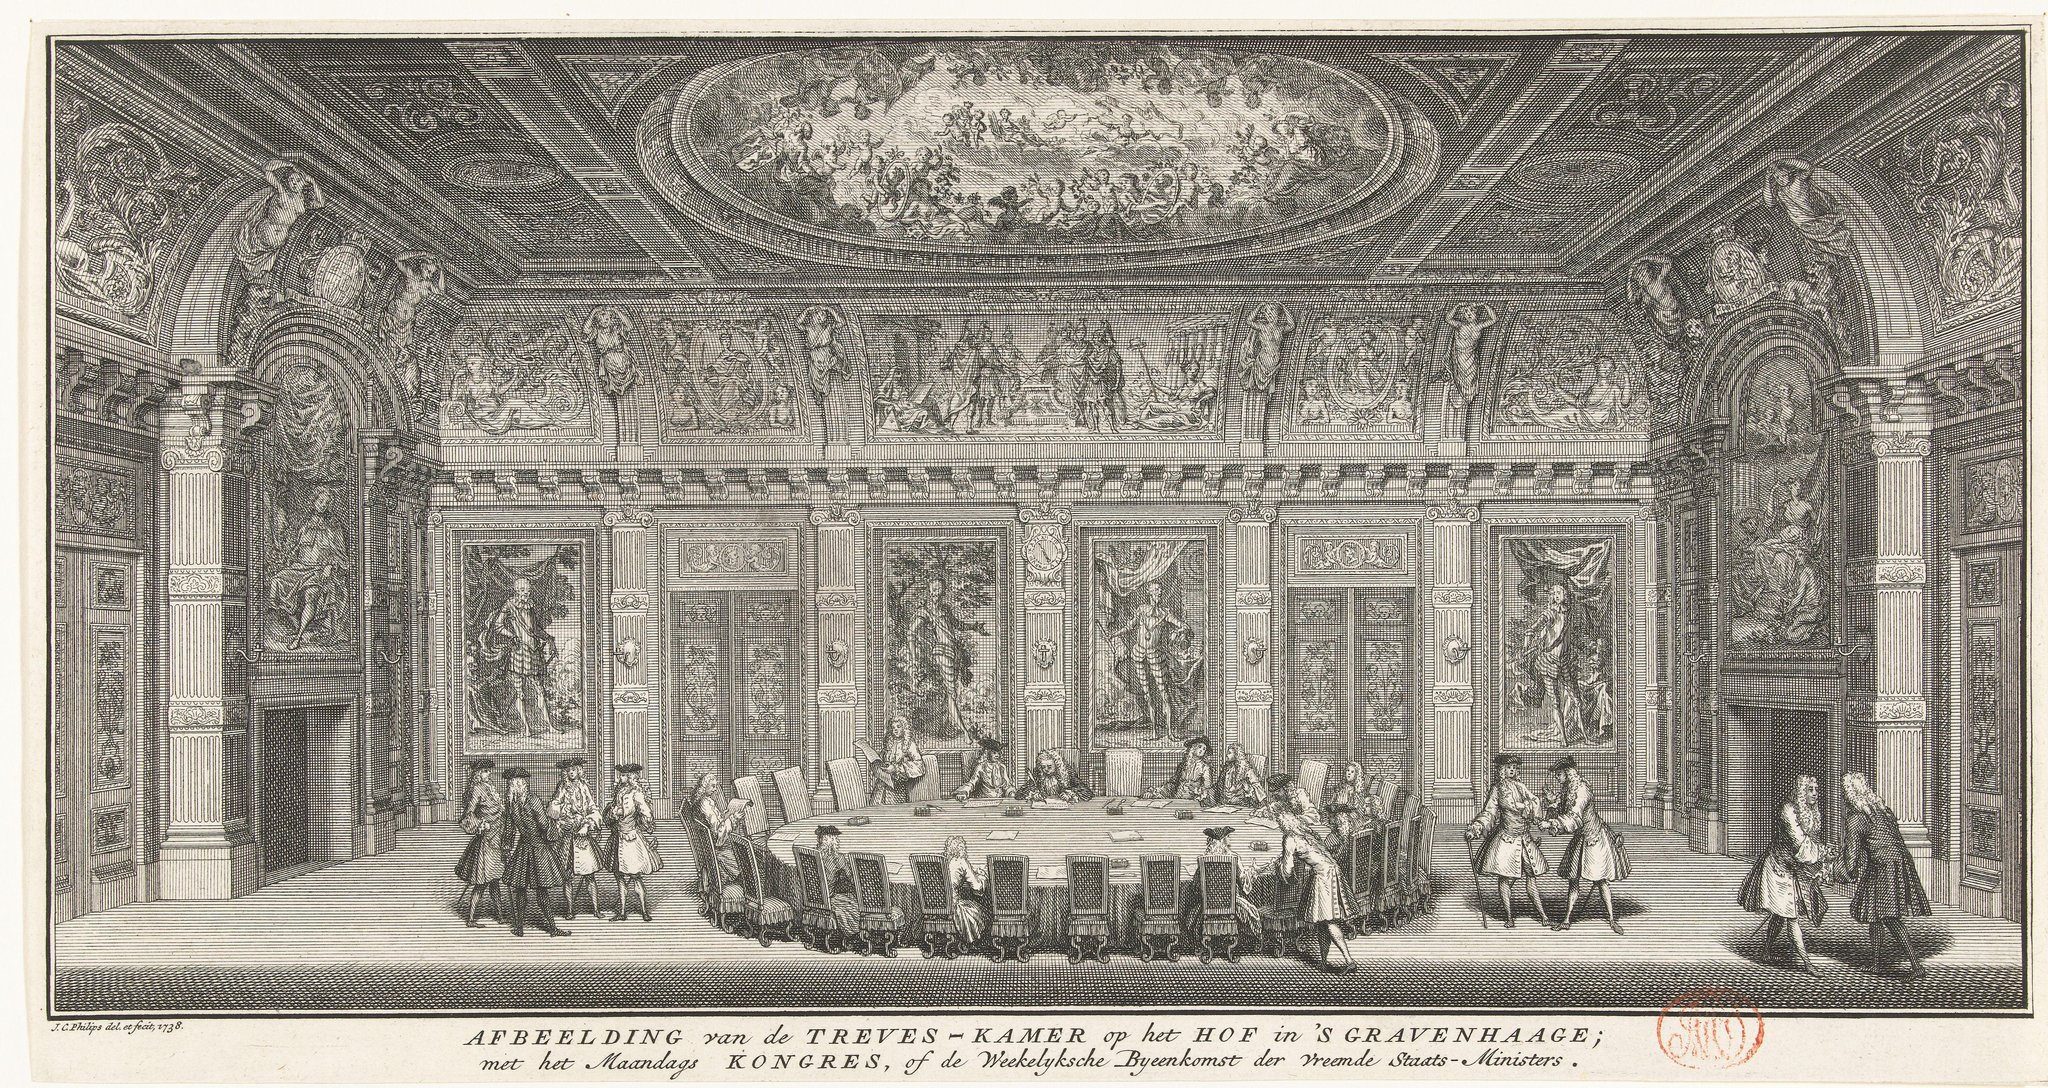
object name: print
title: Wekelijks overleg door de Staten-Generaal in de Trêveszaal, 1738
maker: jan caspar philips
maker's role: draughtsman, print maker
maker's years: 1700-1775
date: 1738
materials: paper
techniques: engraving, etching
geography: northern netherlands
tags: national government, lower house, parliament, chamber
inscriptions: collector's mark: Lugt 195, collector's mark: Lugt 2228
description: Mogelijk gebruikt als illustratie in: Tegenwoordige staat der Vereenigde Nederlanden. Echter niet aangetroffen in (delen 4-8) het exemplaar in de Rijksmuseum Research Library.